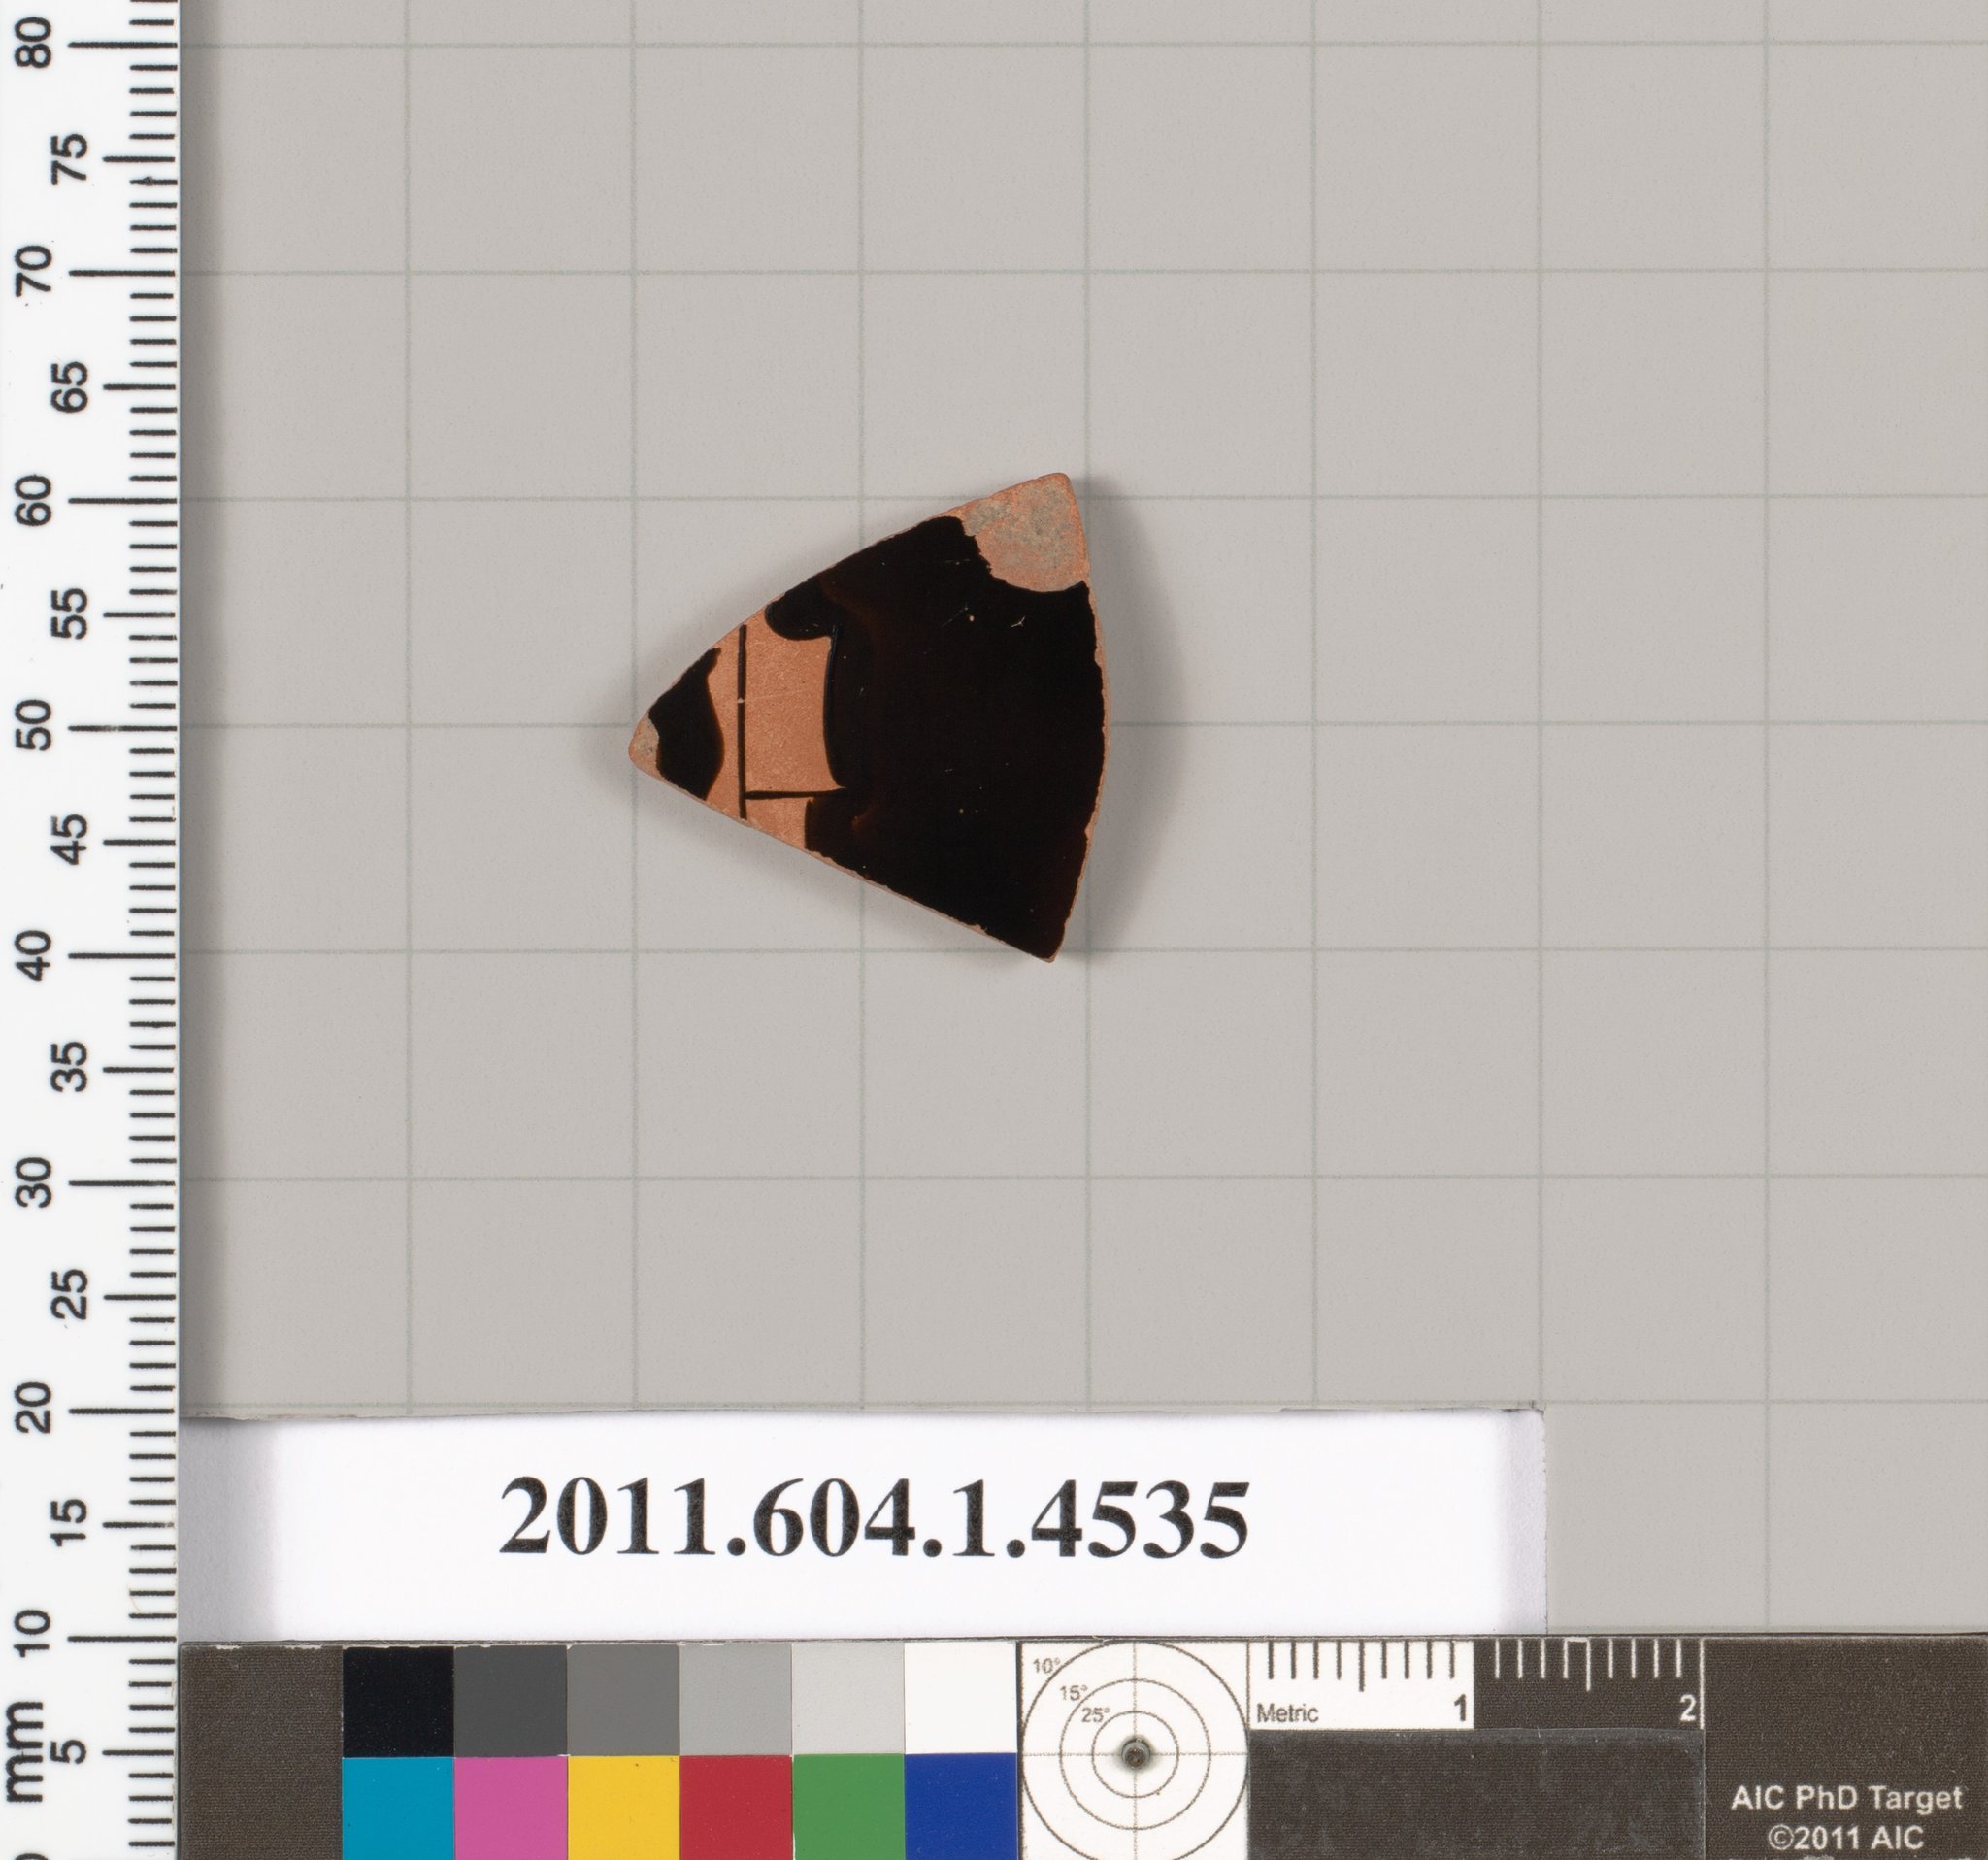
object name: kylix fragment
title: Terracotta fragment of a kylix (drinking cup)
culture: greek, attic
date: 500-470 BCE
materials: terracotta